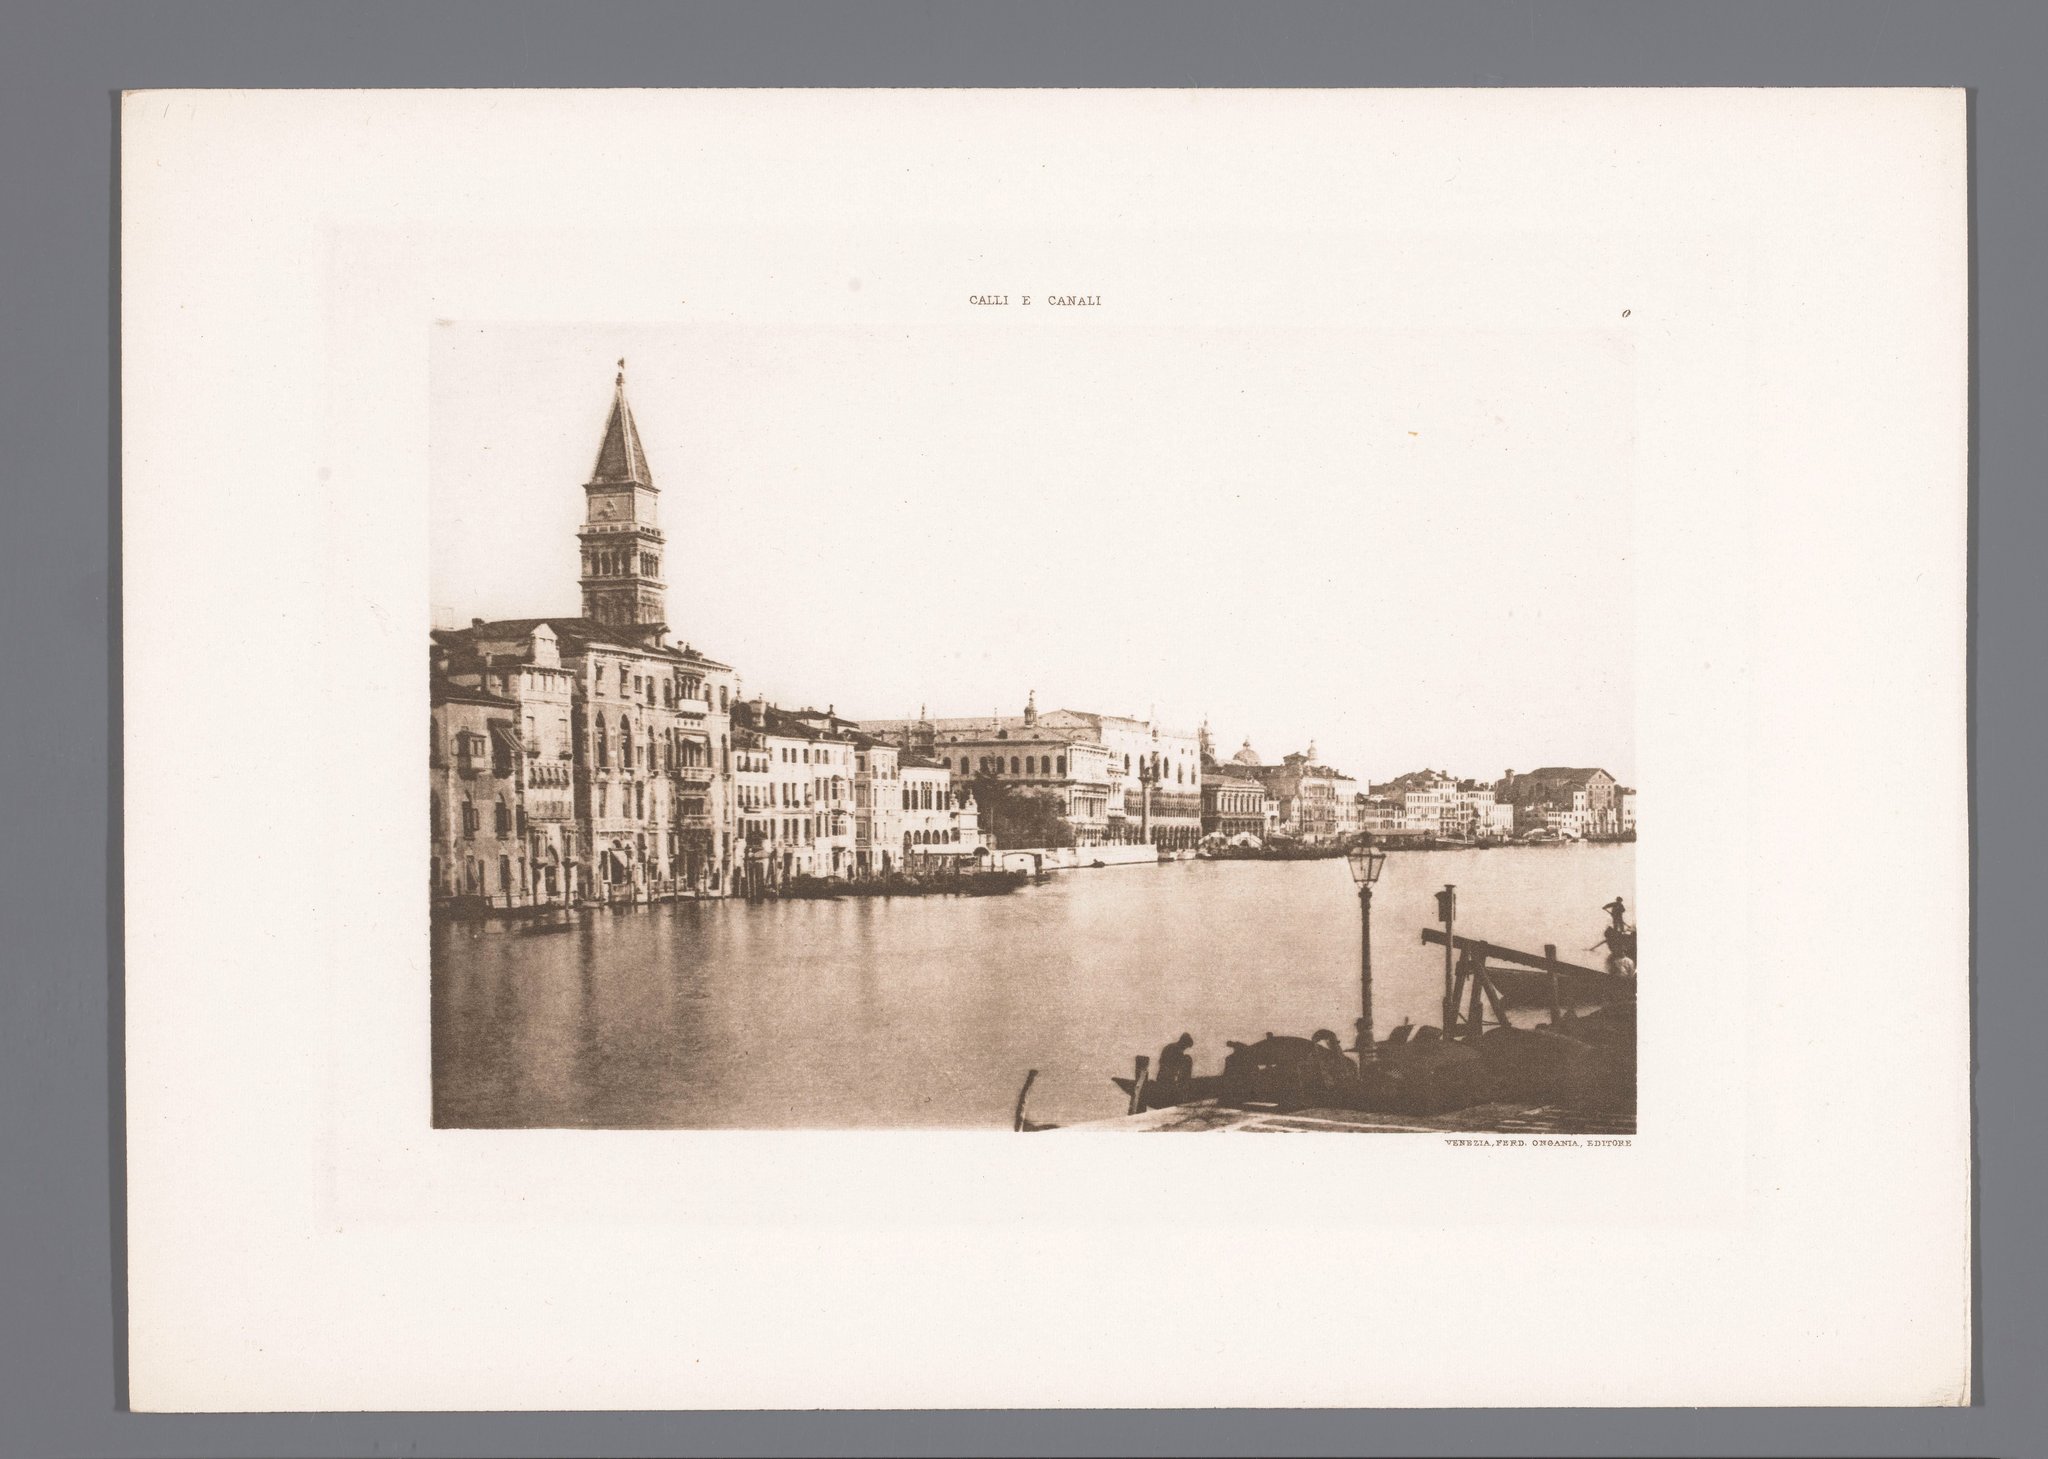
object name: photomechanical print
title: Calli e canali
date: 1888-1898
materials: paper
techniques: photoaquatint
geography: venice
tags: canals, waters (in city), venice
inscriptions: inscription: ‘o’